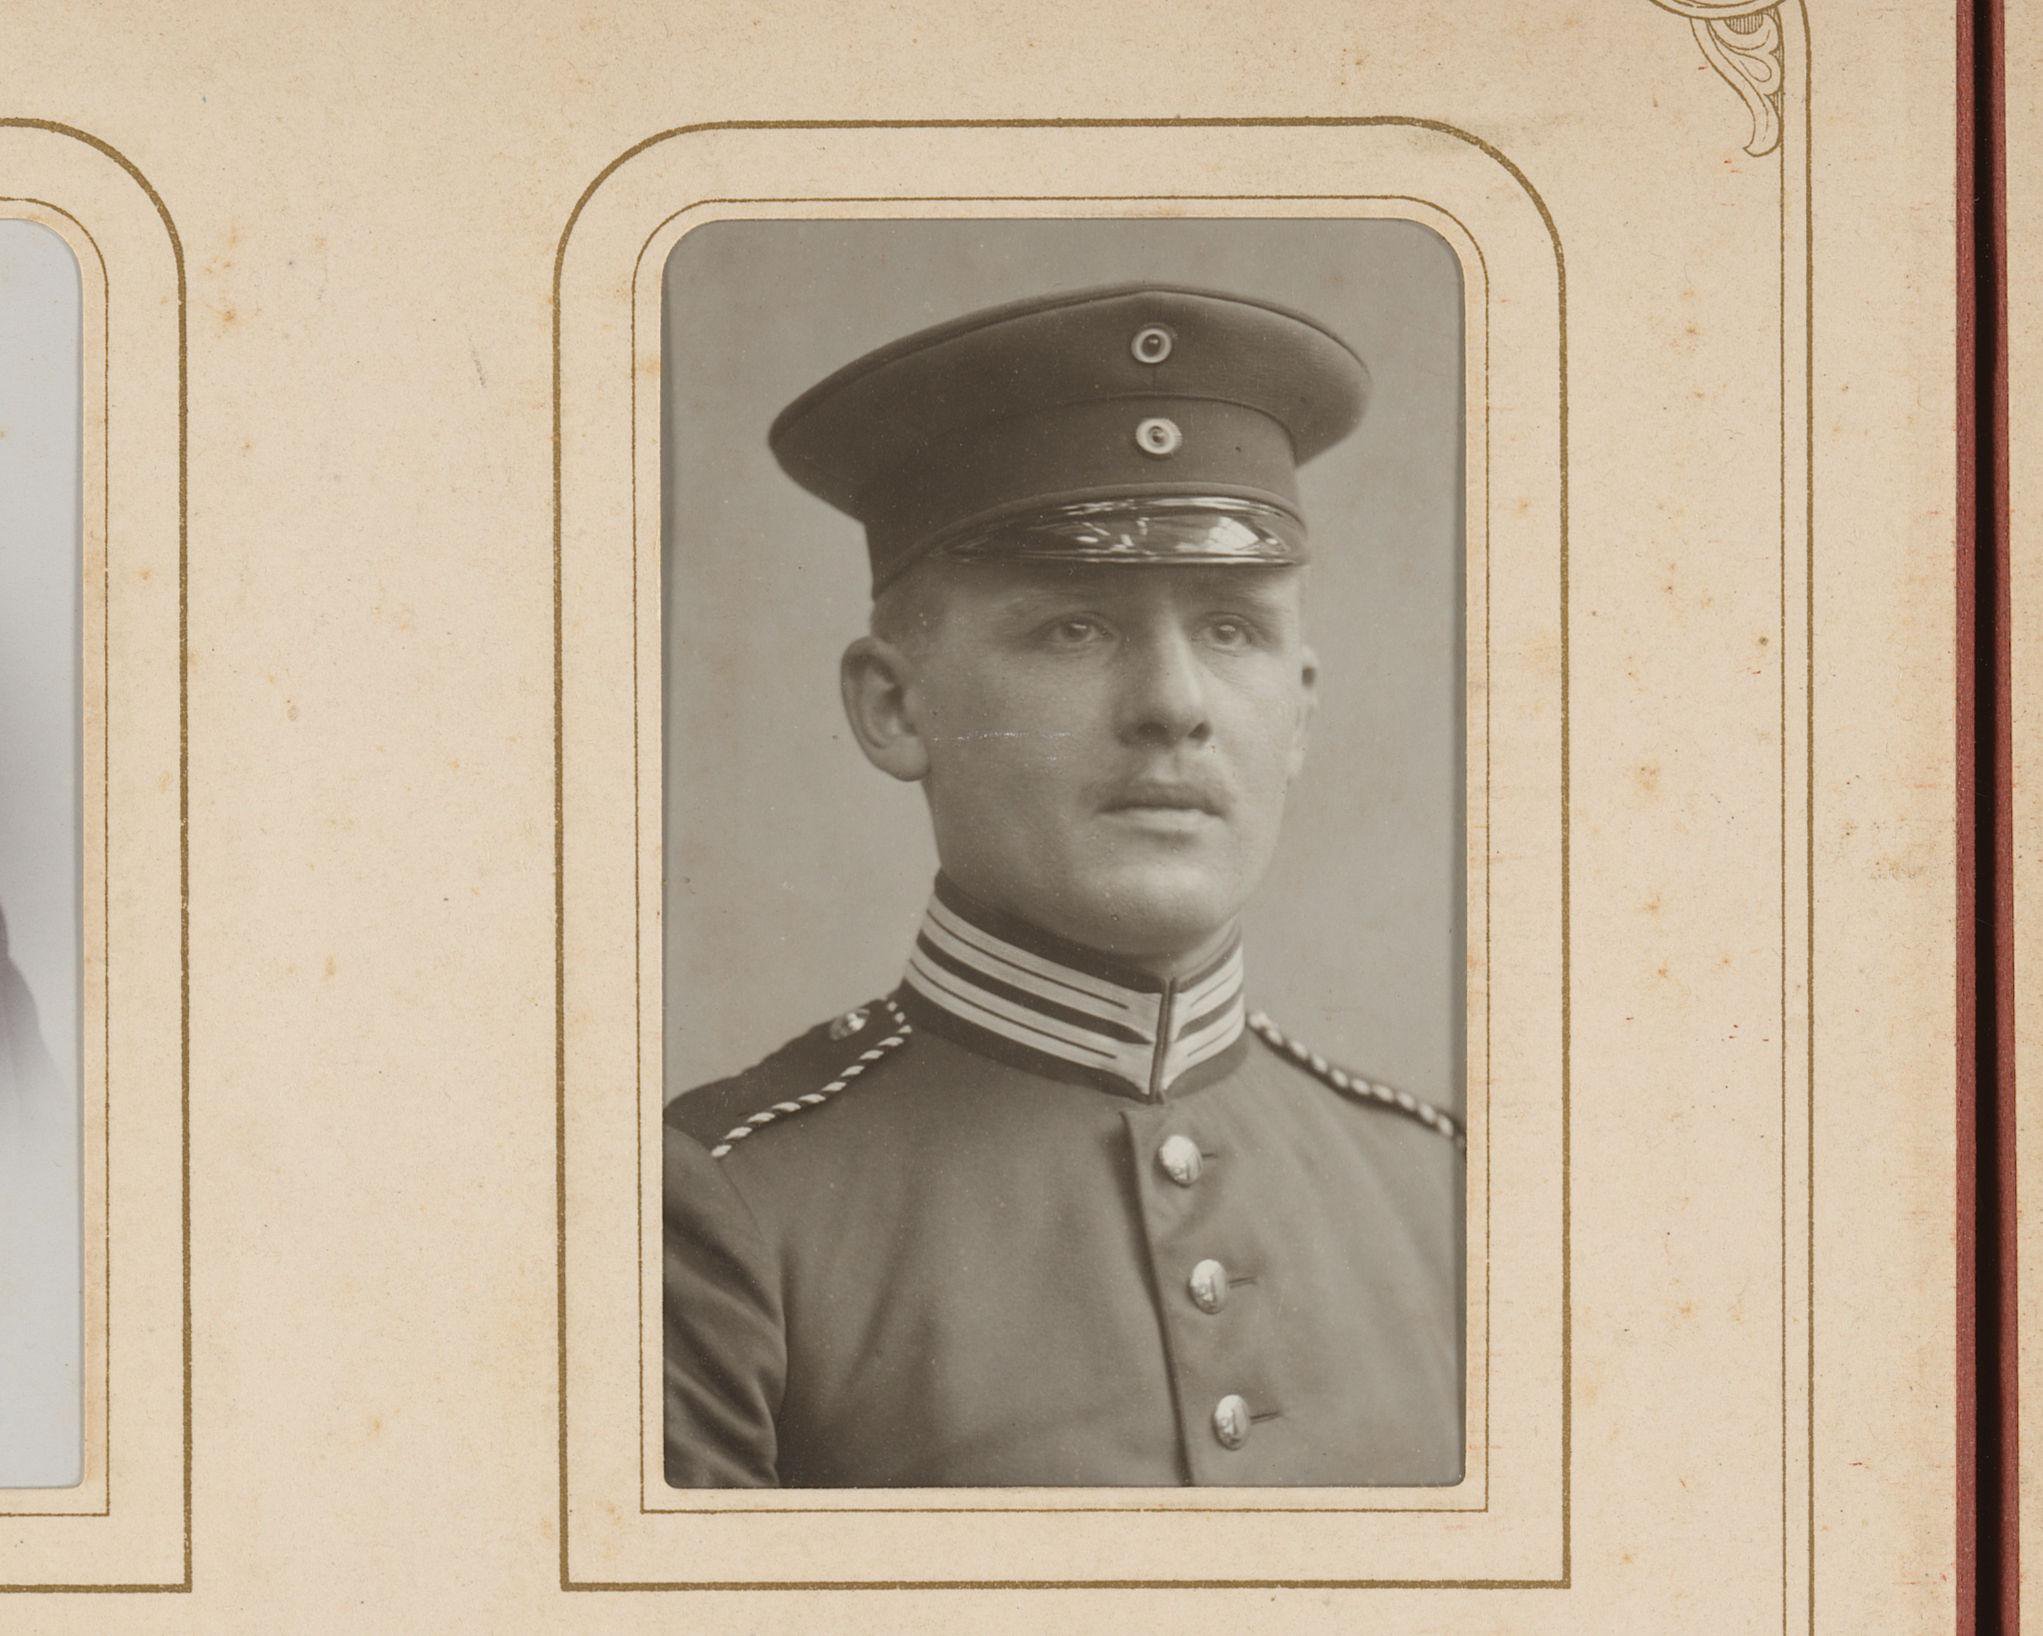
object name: carte de visite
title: Portret van een man in uniform, aangeduid als Heinr. Reuter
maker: hermann noack (fotograaf)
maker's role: fotograaf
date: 1905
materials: cardboard, photographic support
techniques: matte daylight collodion silver print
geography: berlin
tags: historical persons, (military) uniforms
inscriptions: inscription: ‘Photographisch-Artist/ Atelier/ H Noack/ SPECIALITÄT:/ KINDERAUFNAHMEN/ VERGRÖSSERUNGEN/ PLATINOTYPIEN/ AQUARELL - PASTELL/ ETC./ BERLIN N W/ 45 UNTER DEN LINDEN 45/ NEBEN CAFÉ VICTORIA/ VIS-À-VIS CAFÉ BAUER/ TEL. 1, 4661./ AUFNAHMEN/ BEI JEDER WITTERUNG./ GEÖFFNET VON 9-6 UHR./ SONNTAGS VON 10-4 UHR./ DIE PLATTE BLEIBT FÜR NACHBESTELLUNGEN AUFBEWAHRT.’, annotation: ‘1905/ Henri Reuter.’